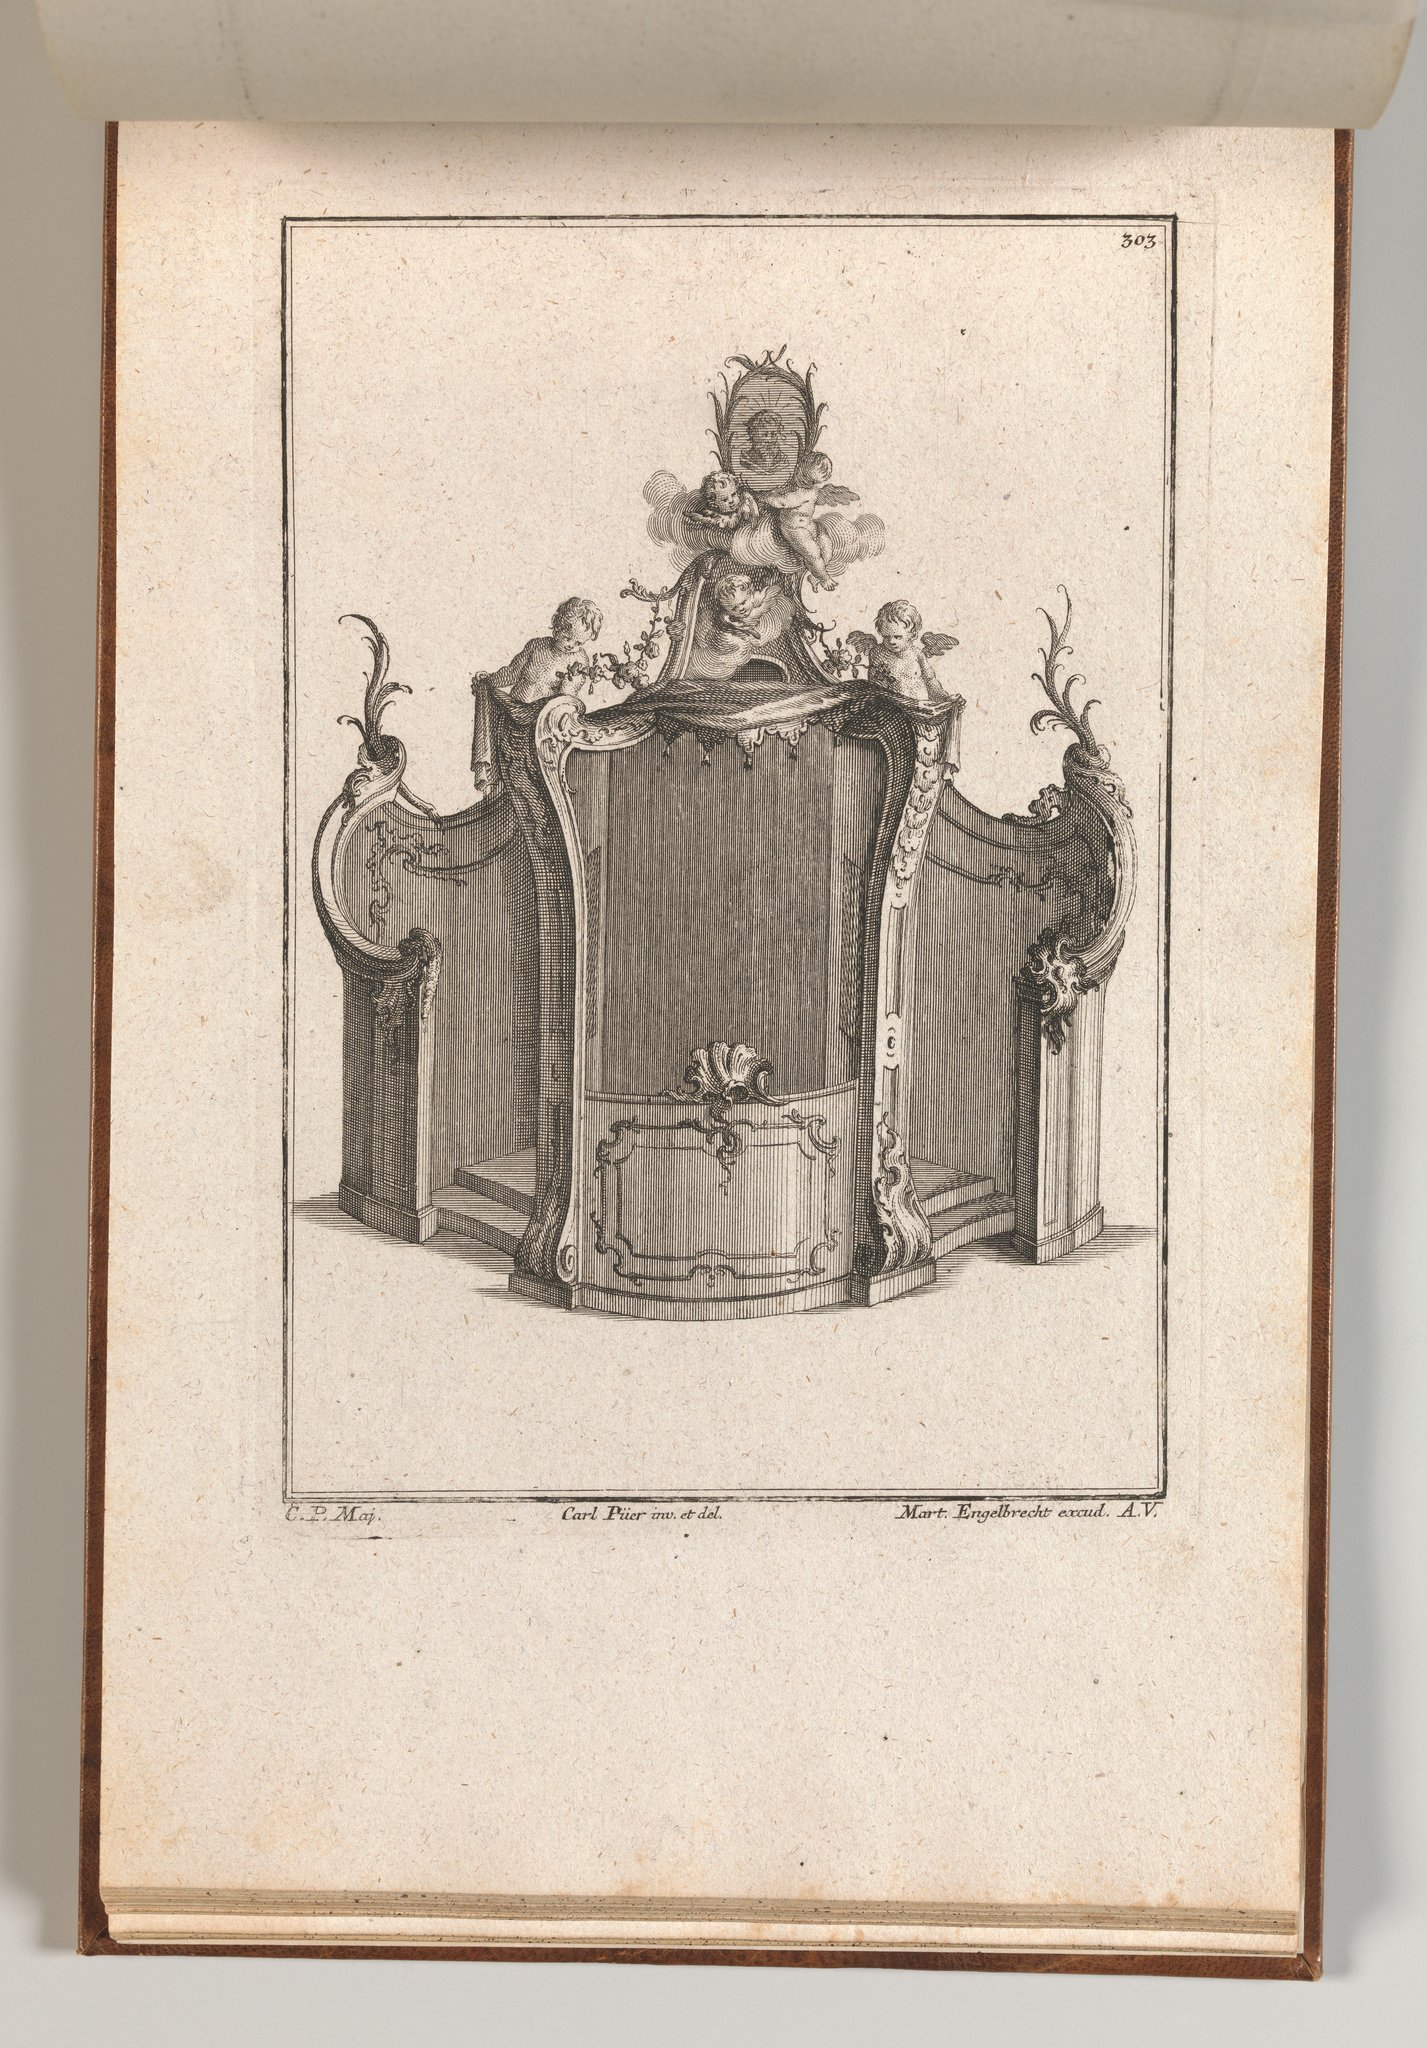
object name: album print ornament architecture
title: Design for a Confessional, Plate 2 from an Untitled Series of Designs for Confessionals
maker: carl pier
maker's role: artist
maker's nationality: german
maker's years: 1700-1790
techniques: etching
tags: ornament